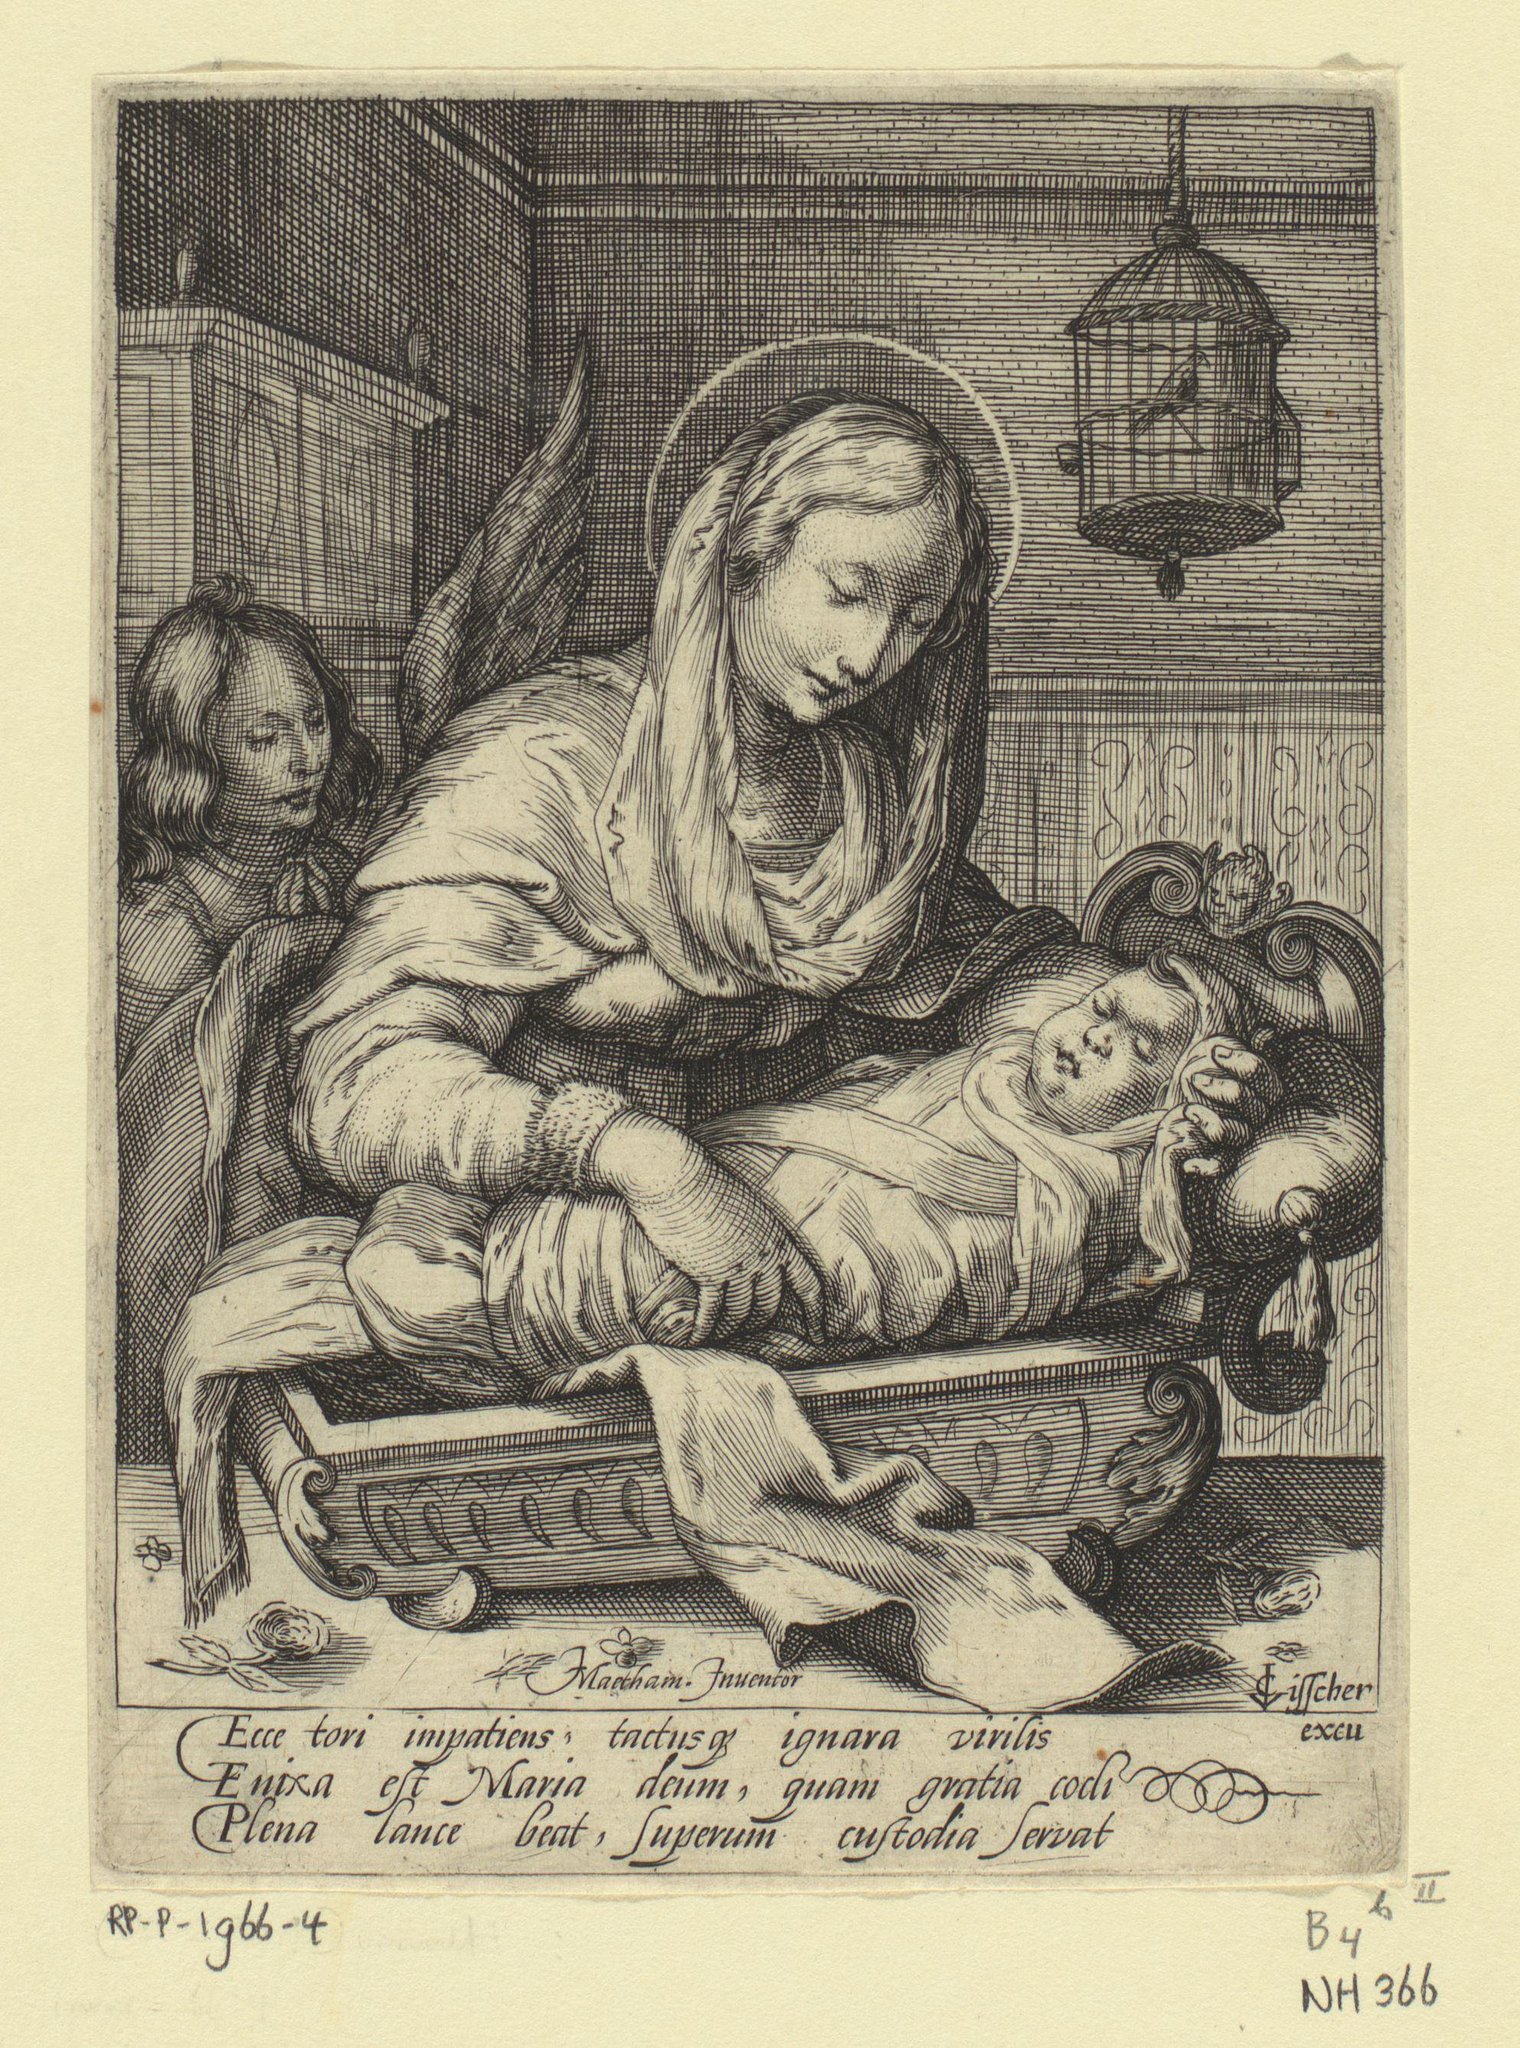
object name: print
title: Maria het kind in de wieg leggend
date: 1610-1614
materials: paper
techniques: engraving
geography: amsterdam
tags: adoration of the christ-child by mary (+ angel(s)), cradle, crib, baby in swaddling clothes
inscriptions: caption: ‘Ecce toris impatiens’, collector's mark: Lugt 2228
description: Maria legt het ingebakerde Christuskind in een wieg, in een interieur. Achter haar staat een engel. Aan het plafond hangt een vogelkooi.